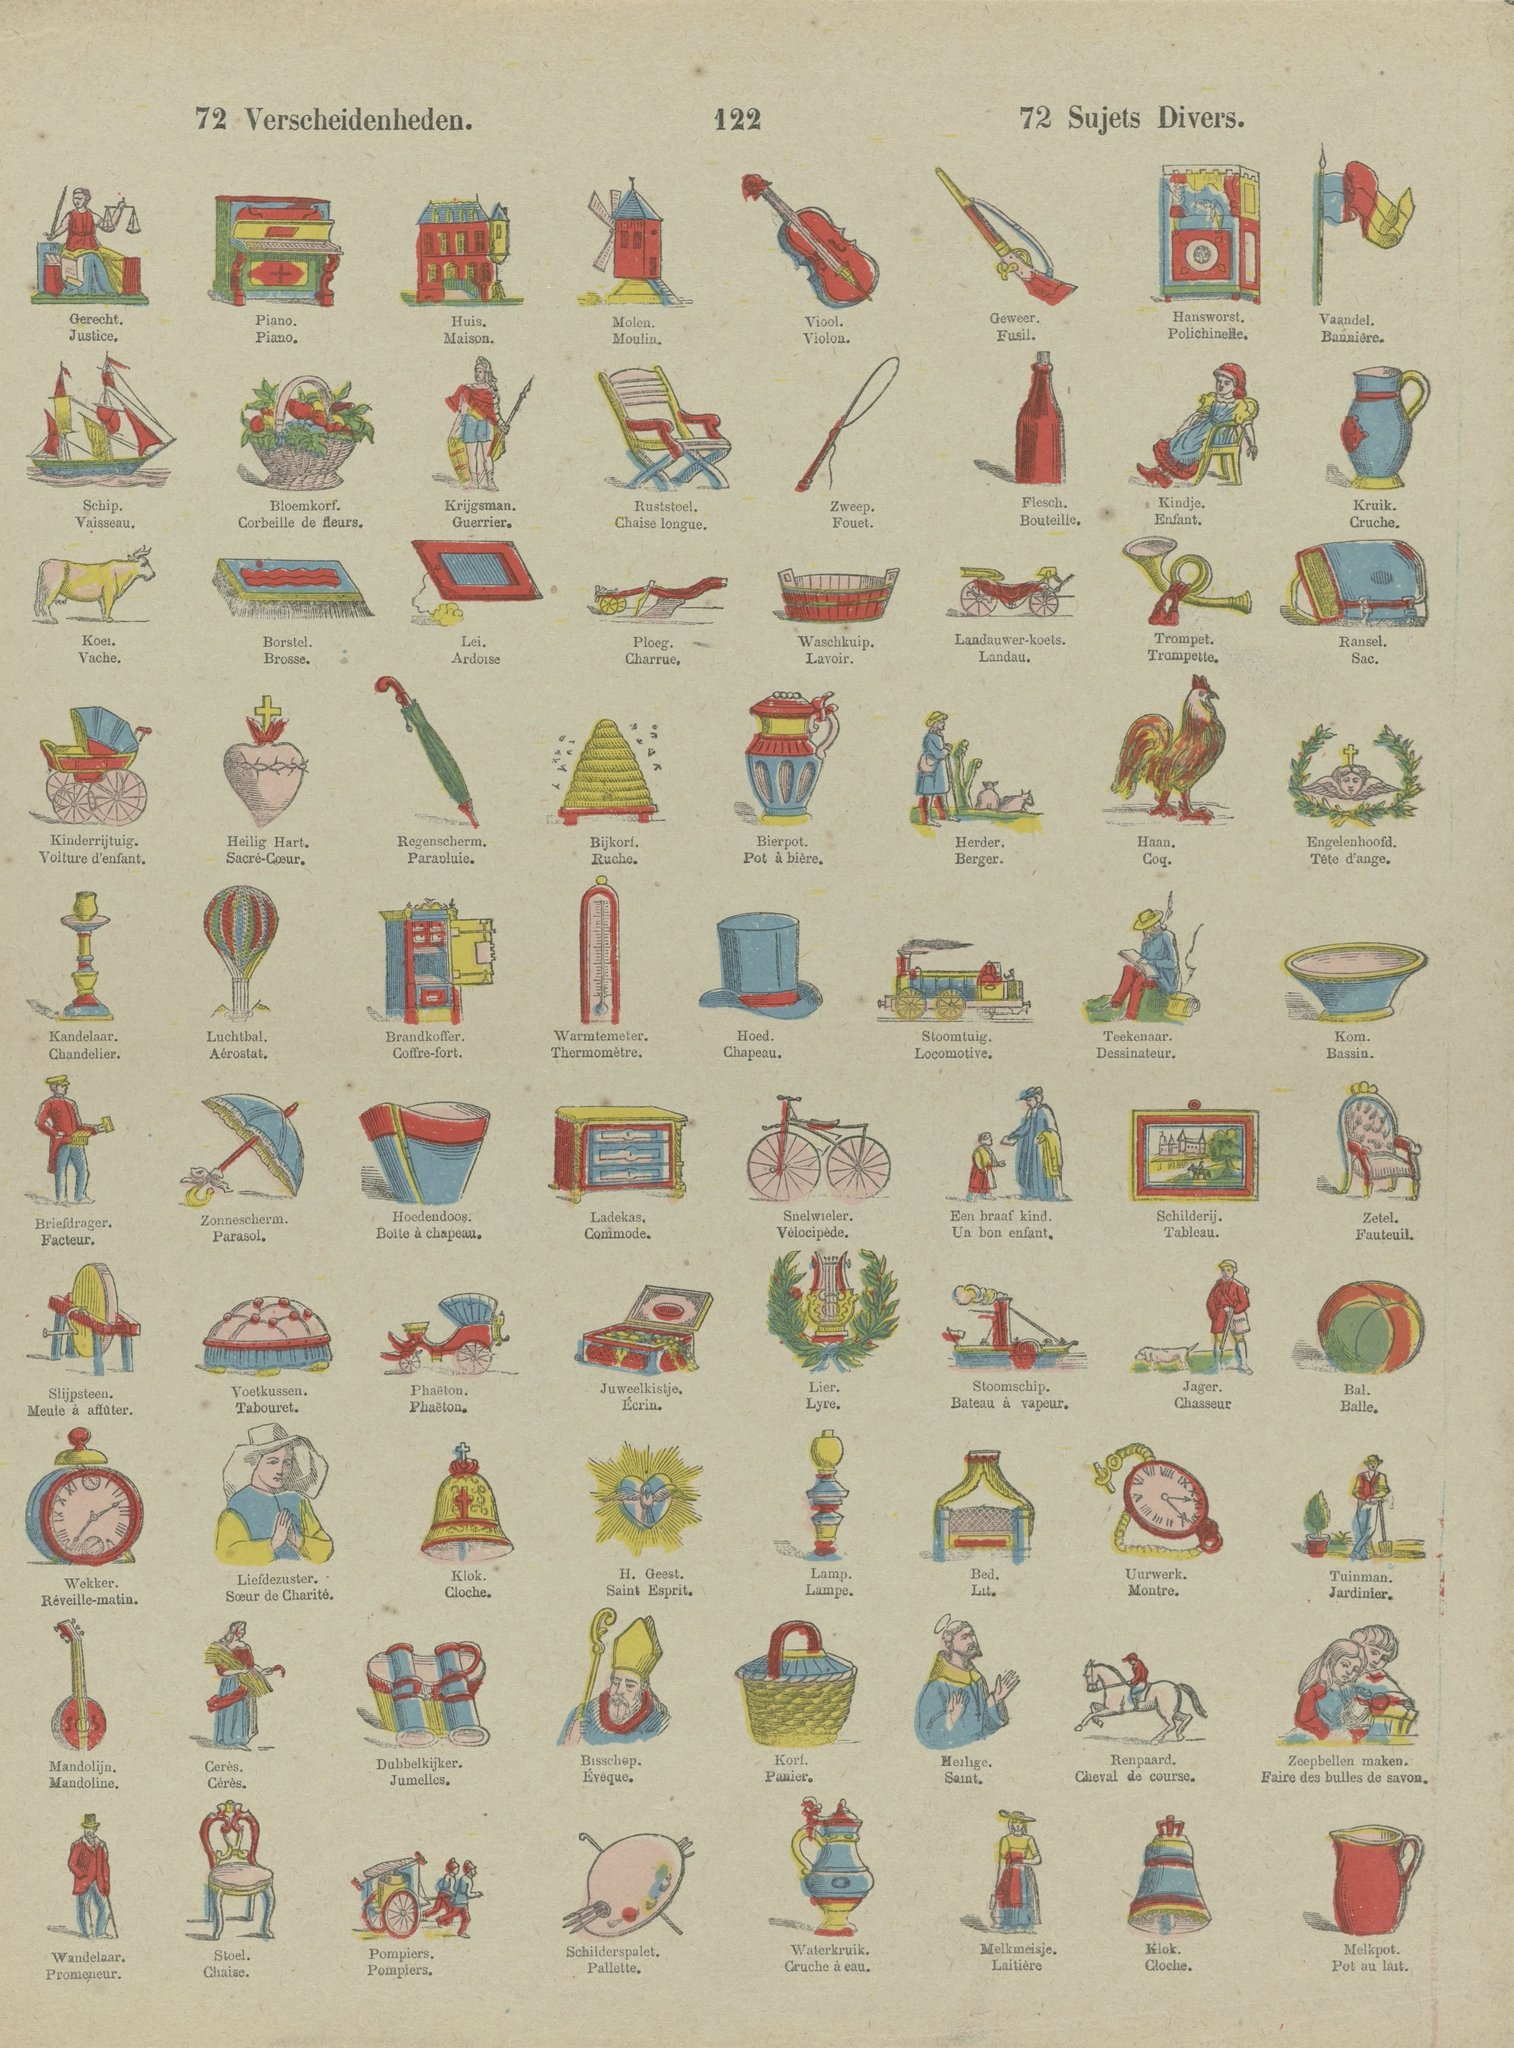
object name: popular print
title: 72 Verscheidenheden / 72 Sujets divers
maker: Anonymous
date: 1833-1911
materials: paper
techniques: lithograph, letterpress printing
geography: turnhout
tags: animals, characters (human types), (household) utensils and implements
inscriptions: collector's mark: Lugt 2760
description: Blad met 80 voorstellingen van verschillende voorwerpen, dieren en figuren. Onder elke voorstelling een onderschrift in het Nederlands en in het Frans. Genummerd midden boven: 122.